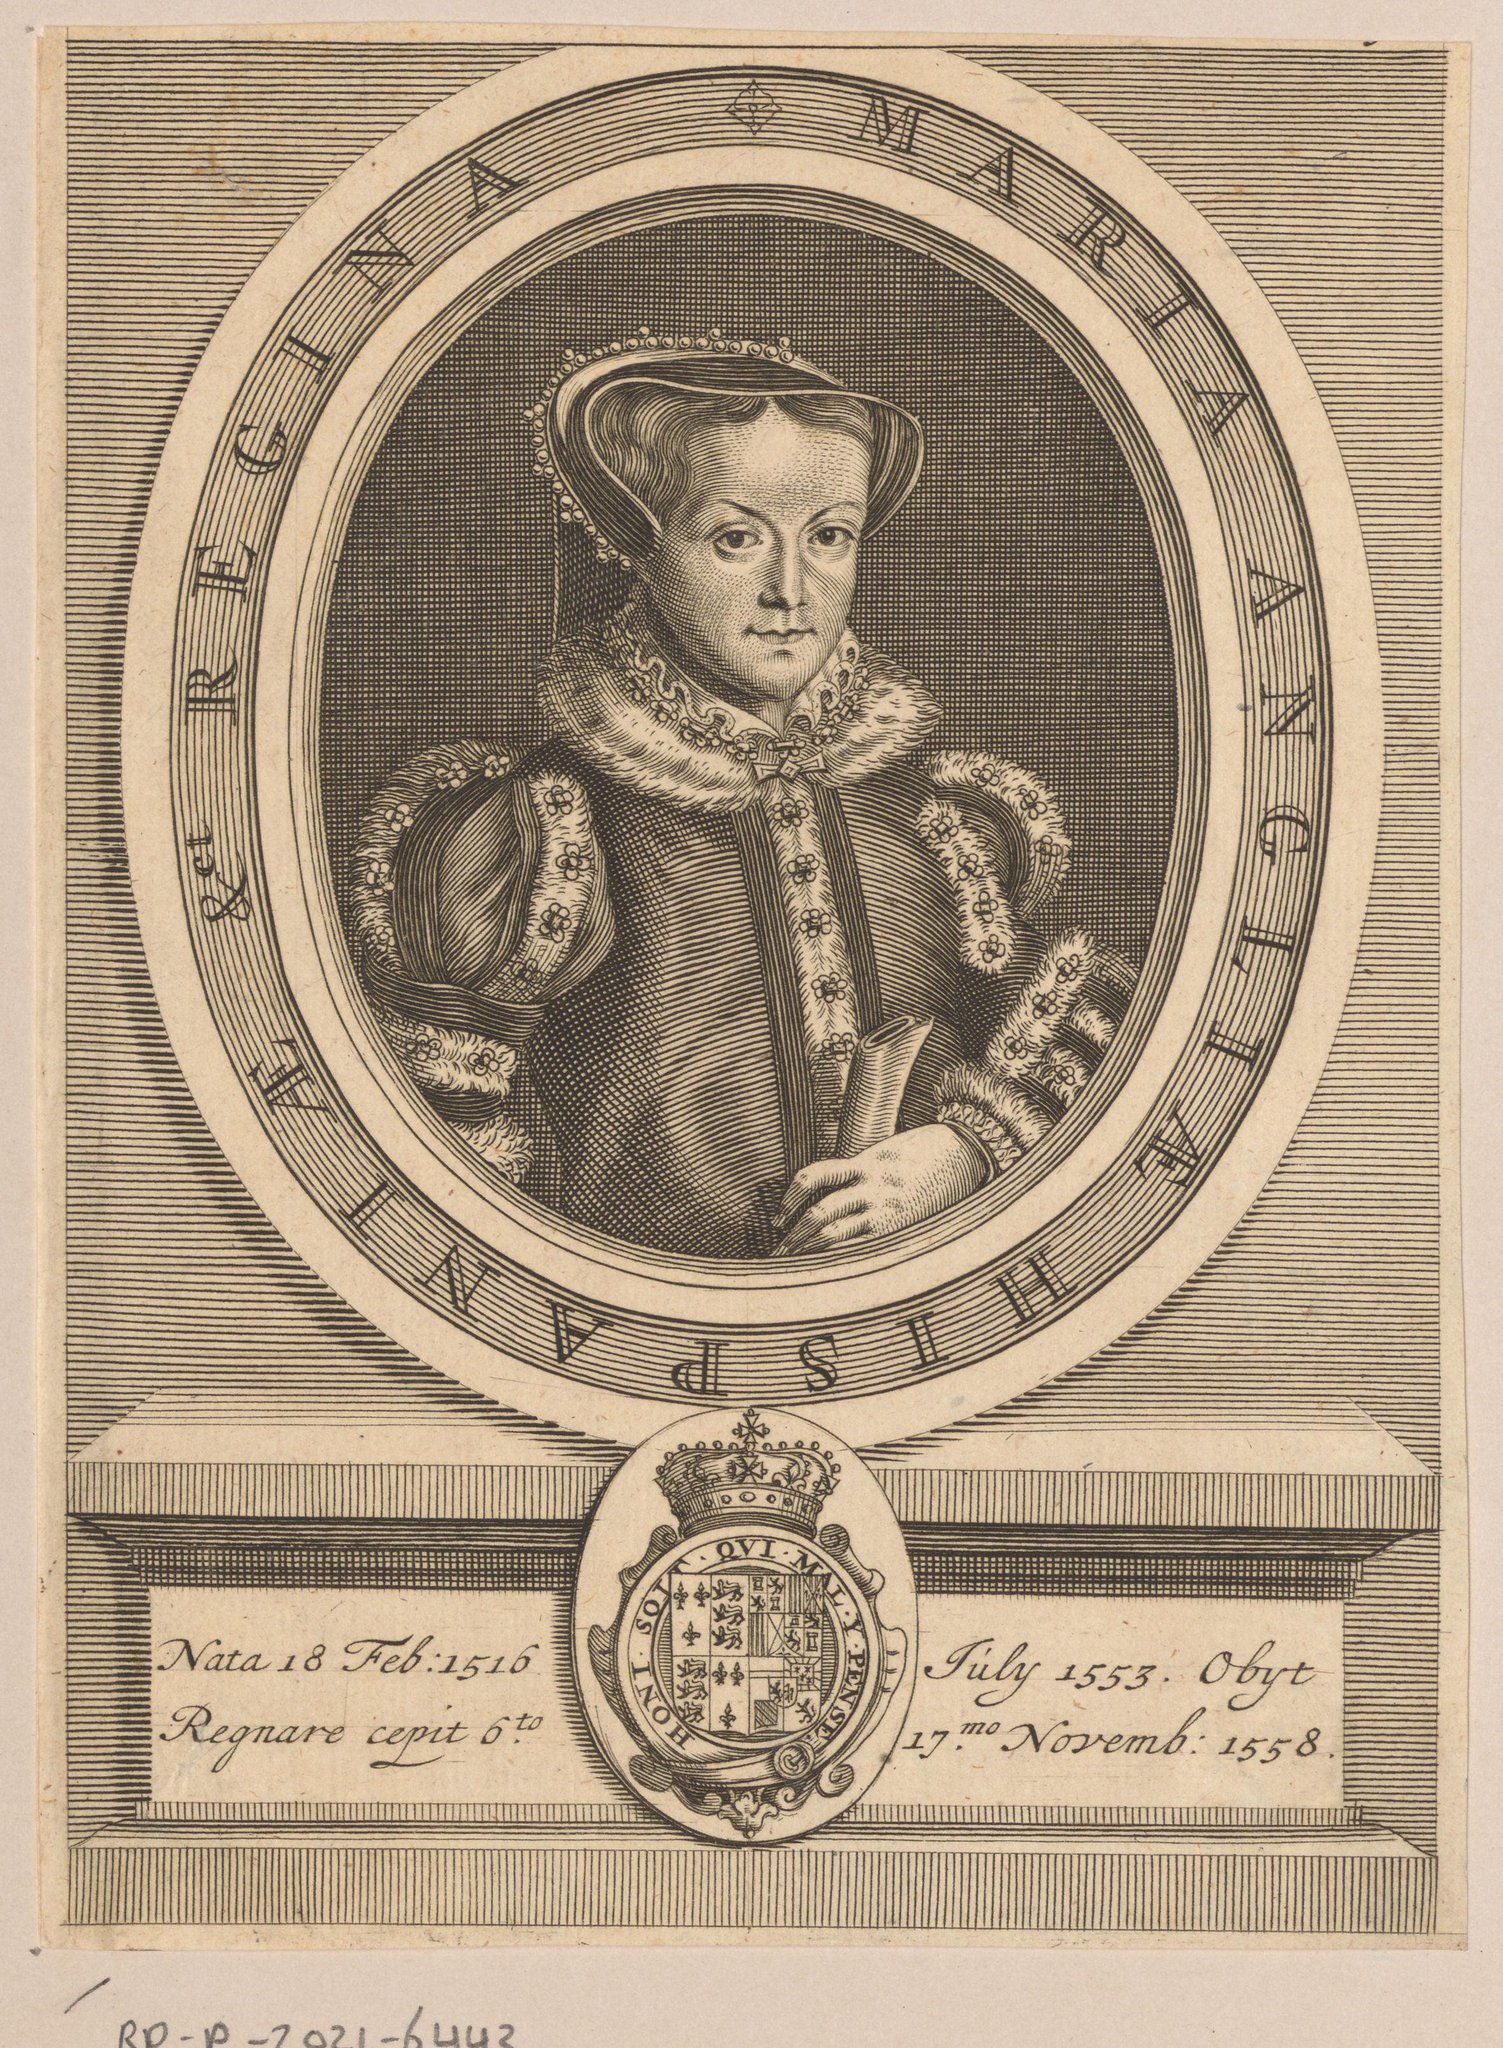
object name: print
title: Portret van Maria I van Engeland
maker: Anonymous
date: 1681-1710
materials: paper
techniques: engraving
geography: england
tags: london, historical persons - bb - woman, ornament ~ medallion, queen, armorial bearing, heraldry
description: Met onderschrift en randschrift in het Latijn.